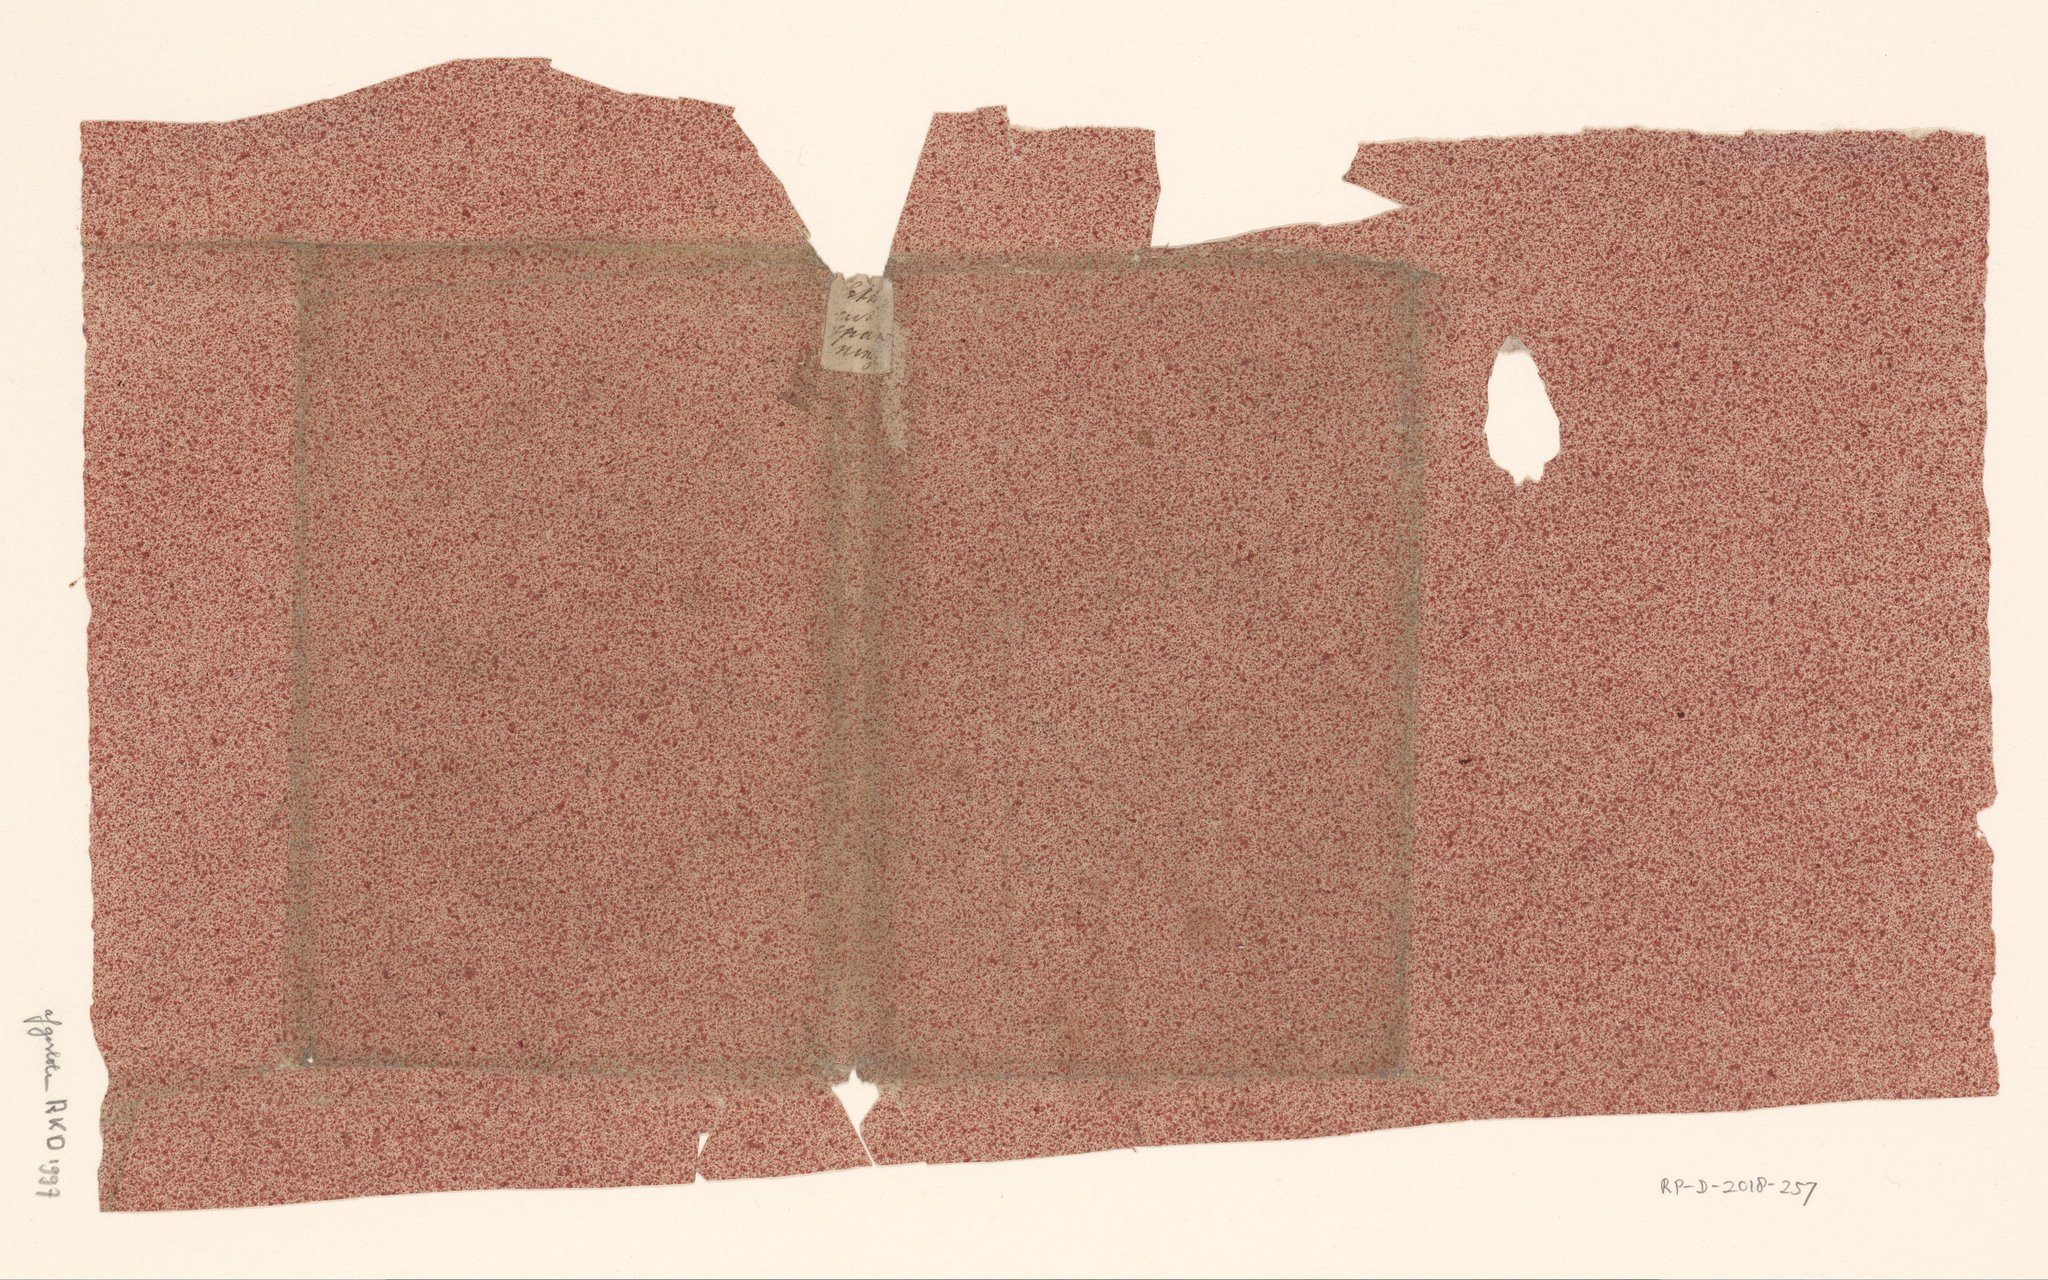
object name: wrapper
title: Rood gespikkeld papier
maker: Anonymous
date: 1750-1900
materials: paint, paper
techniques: splatter marble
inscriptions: collector's mark: Lugt 2228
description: Rood gespikkeld papier. Op de rug een etiket met opschrift: '..uitspanning'. Gebruikt als omslag, met insnijdingen bij de rug.